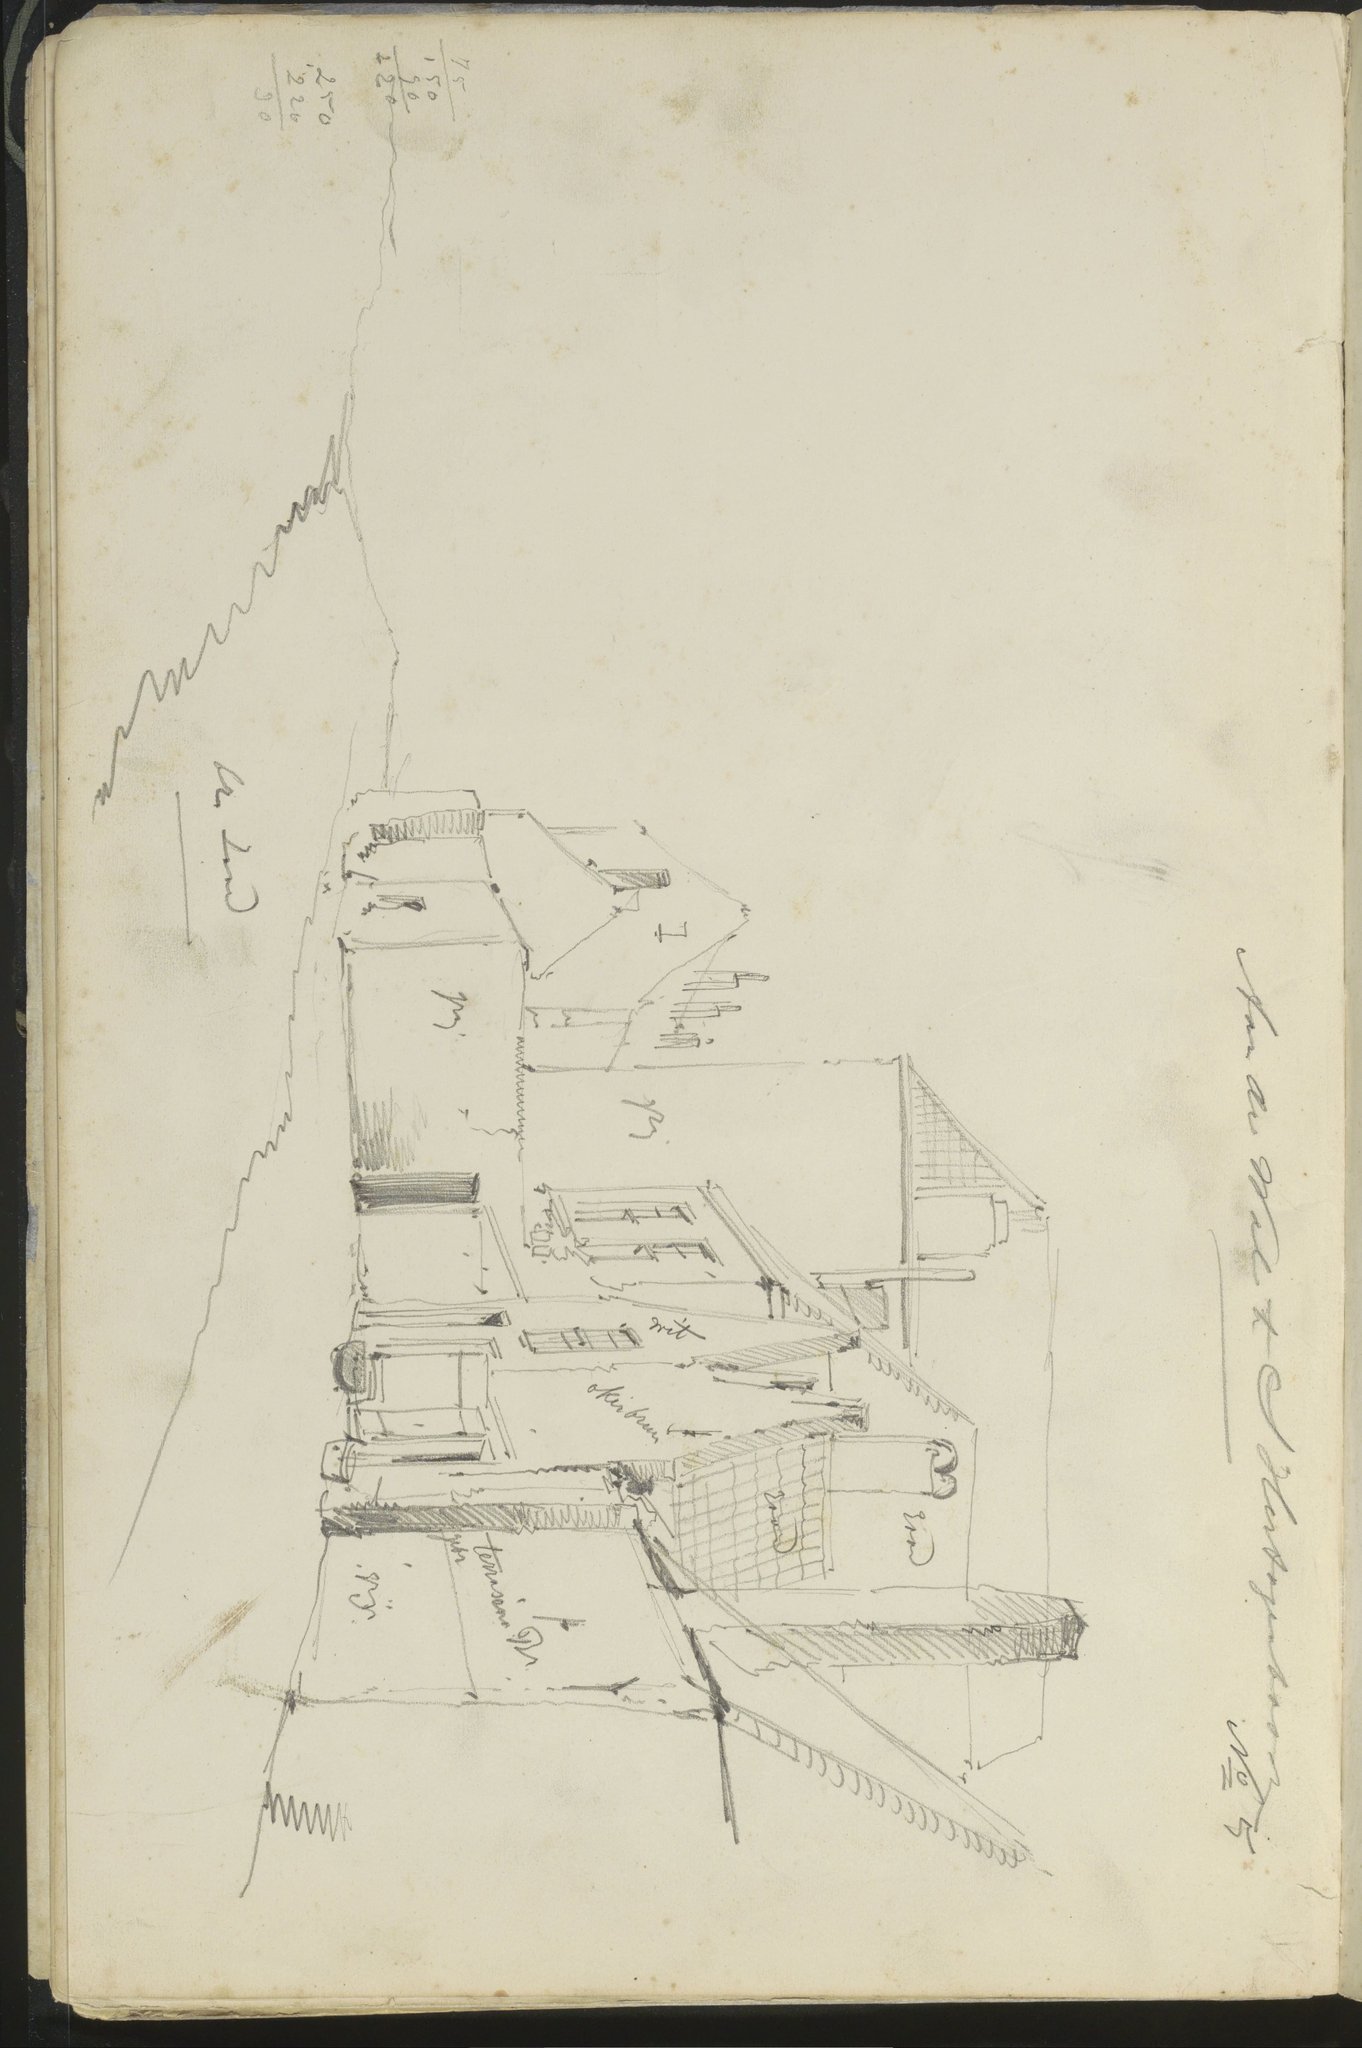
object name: sketchbook leaf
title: Straat aan de wal te Den Bosch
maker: willem koekkoek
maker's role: draughtsman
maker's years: 1839-1895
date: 1849-1895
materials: paper, pencil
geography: den bosch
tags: street, den bosch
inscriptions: annotation: ‘Aan de Wal te s Hertogenbosch/ No 5’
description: Blad 5 verso uit een schetsboek met 35 bladen.